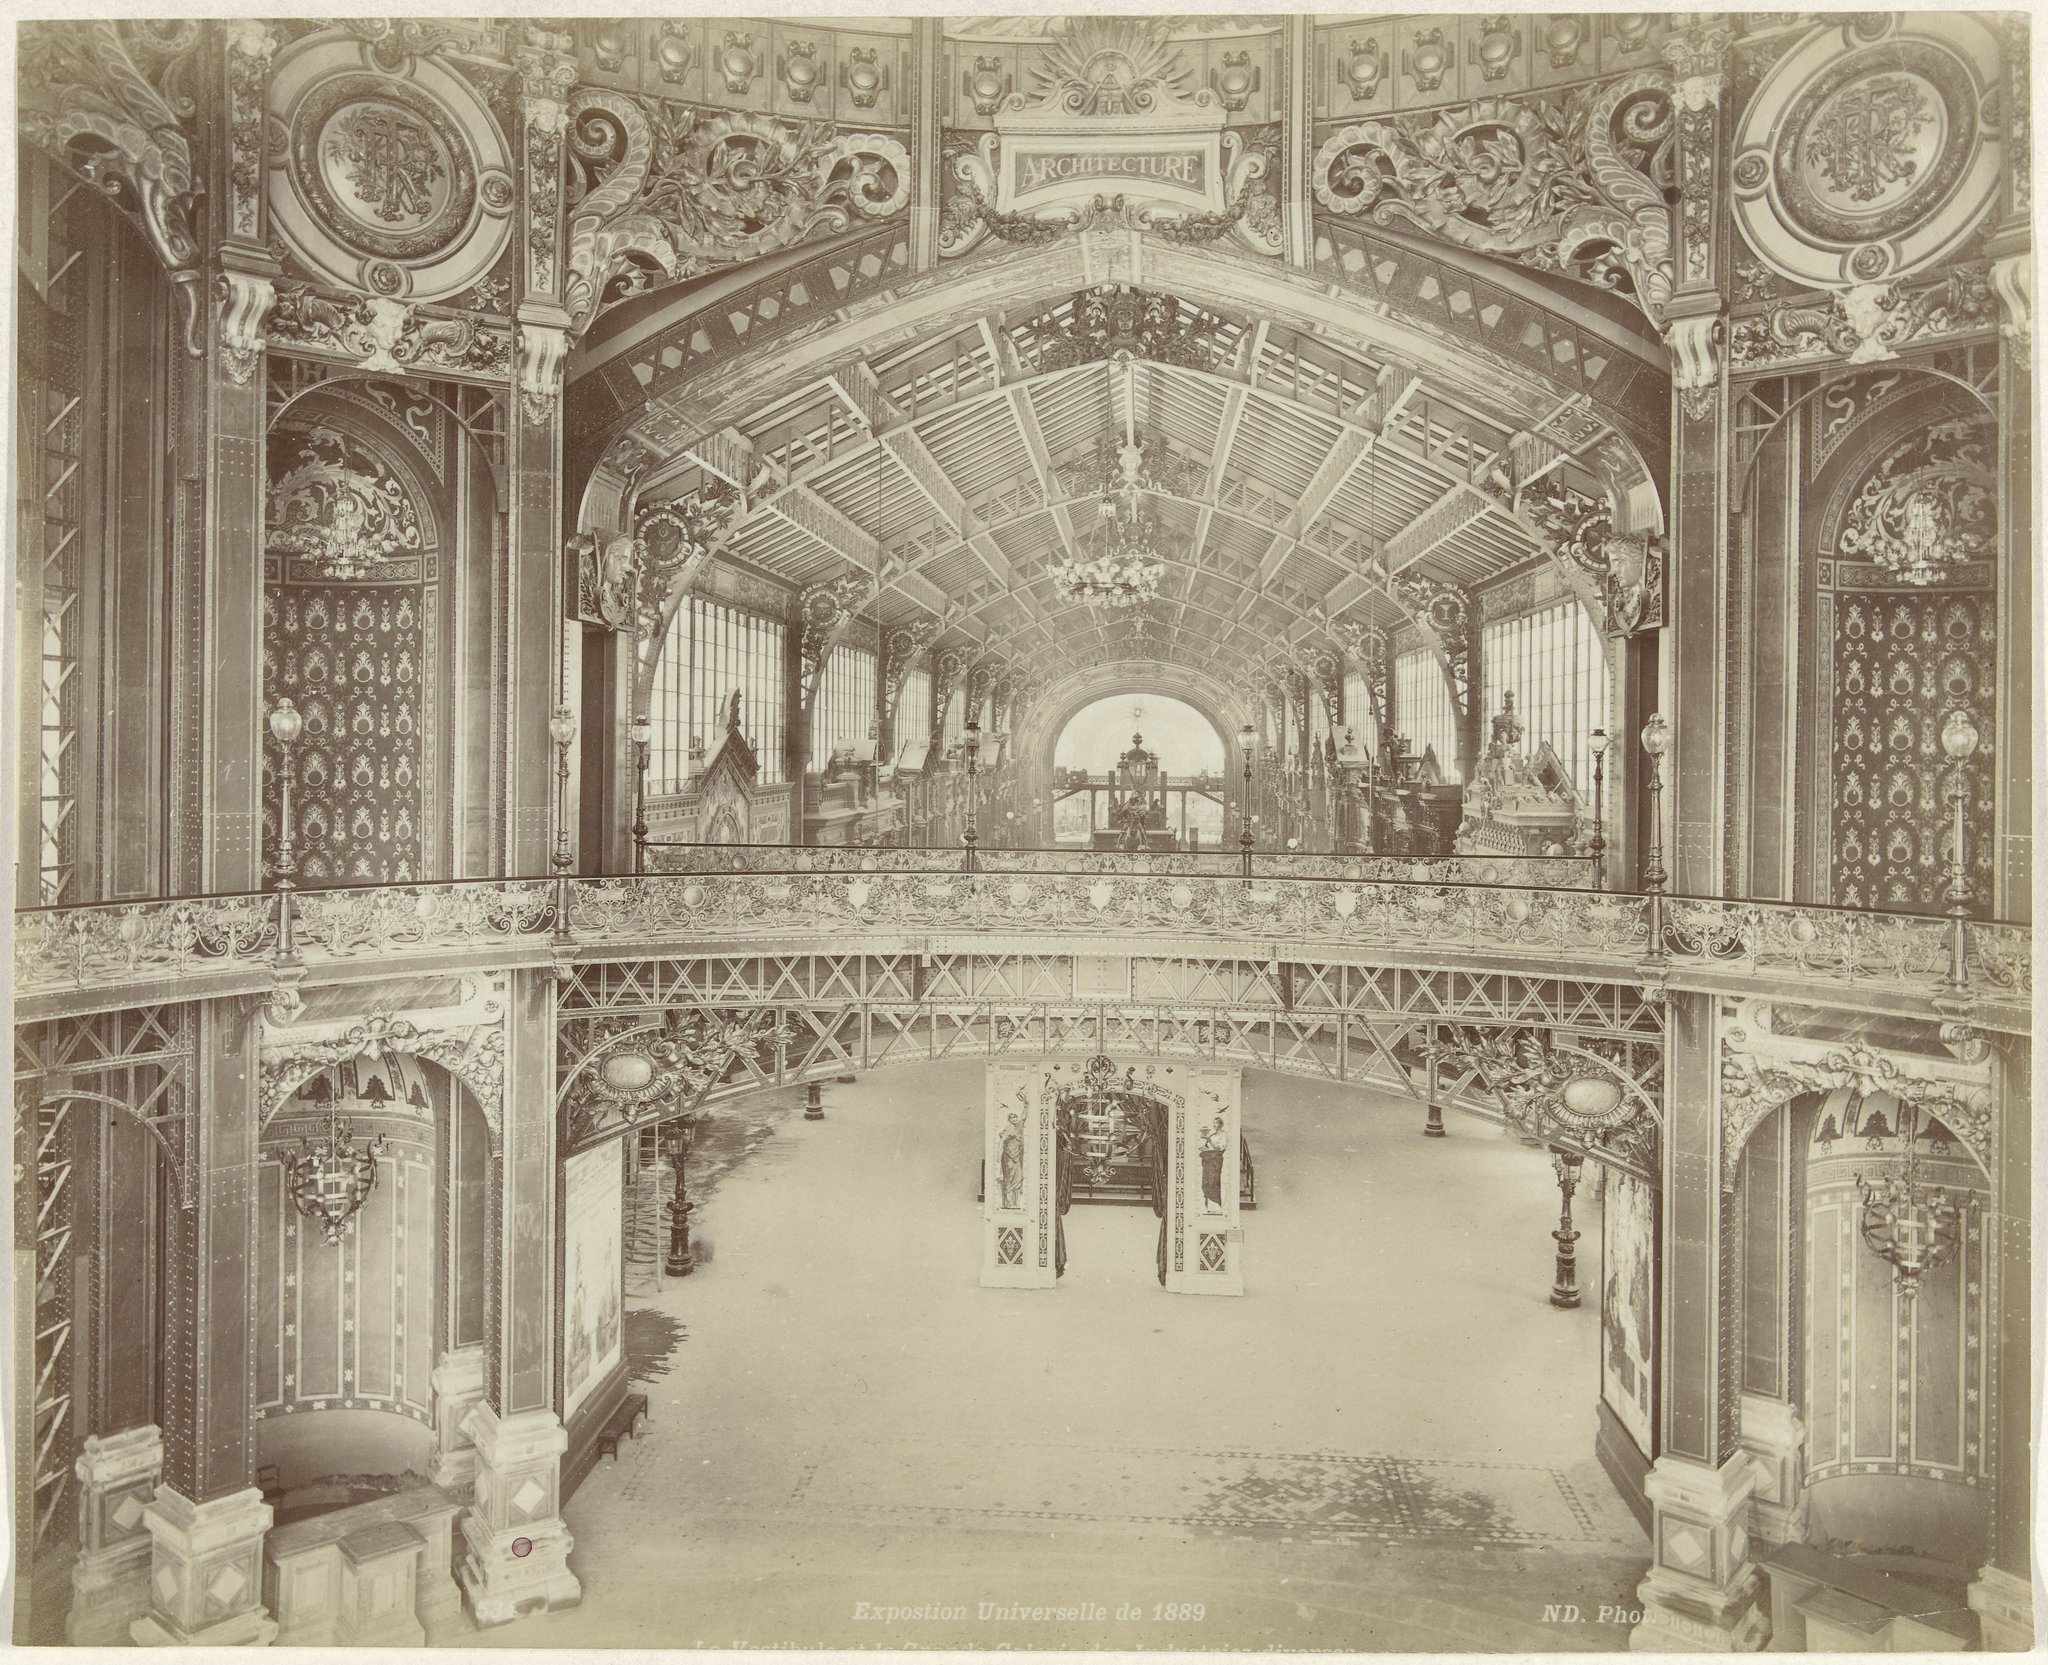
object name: photograph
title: Exposition Universelle de 1889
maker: j. réségotti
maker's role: publisher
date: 1889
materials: paper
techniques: albumen print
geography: paris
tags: world fair, world exhibition, paris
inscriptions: inscription: ‘Exposition Universelle de 1889/ La Vestibule et la Grande Galerie [...]/ ND. Phot.’, stamp: ‘J. Réségotti/ Editeur/ 8 Rue Vivienne/ Paris’, number: ‘14’